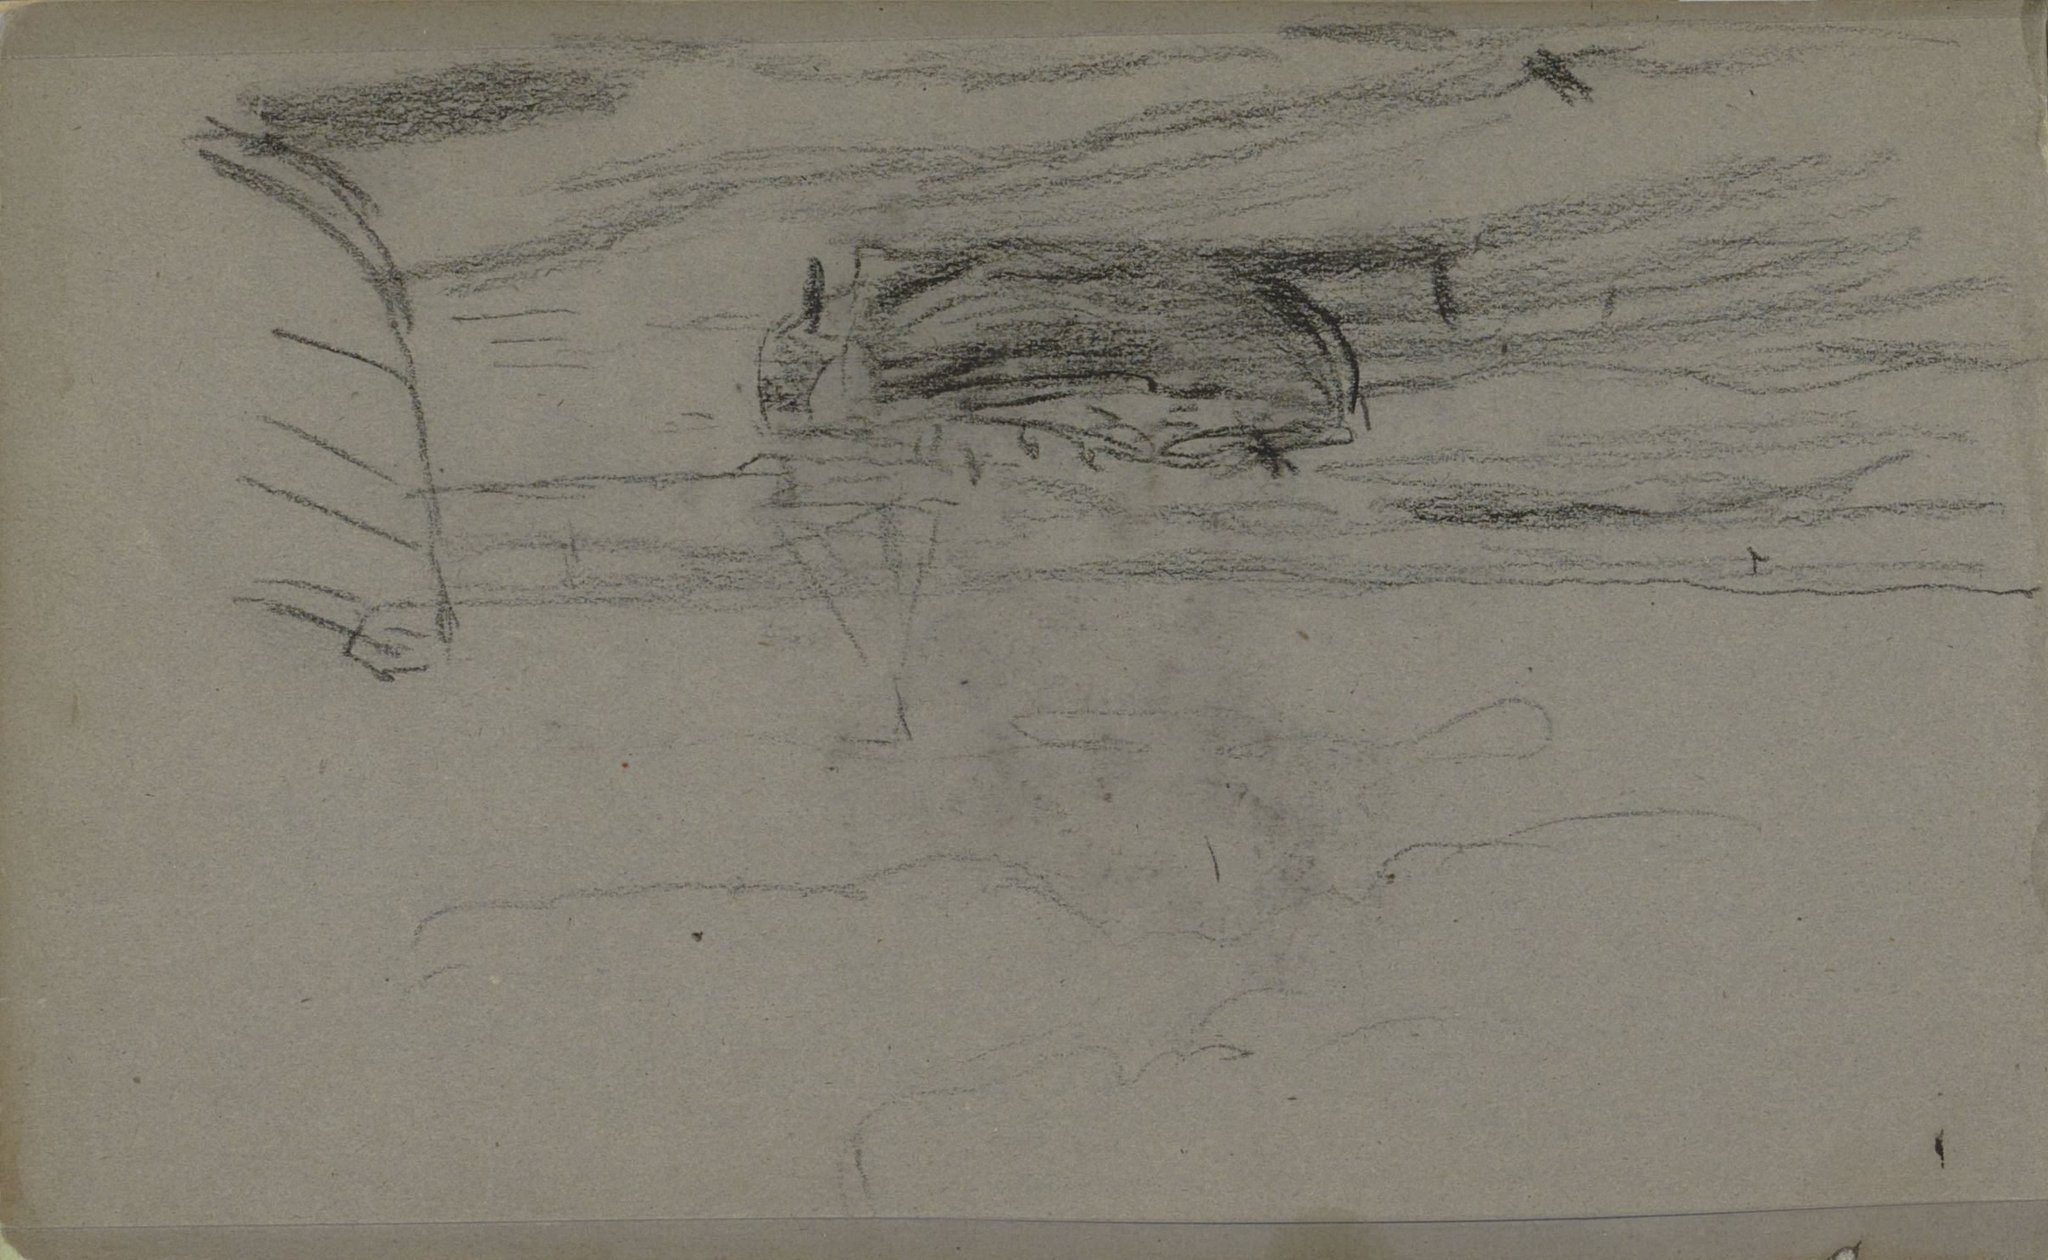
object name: sketchbook leaf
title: Roeiboot op het strand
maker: jozef israëls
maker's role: draughtsman, painter, print maker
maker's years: 1824-1911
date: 1834-1911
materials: chalk, paper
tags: ships, boats on land, beached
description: Op de achtergrond een zeilboot. Blad 32 verso uit een schetsboek met 42 bladen.